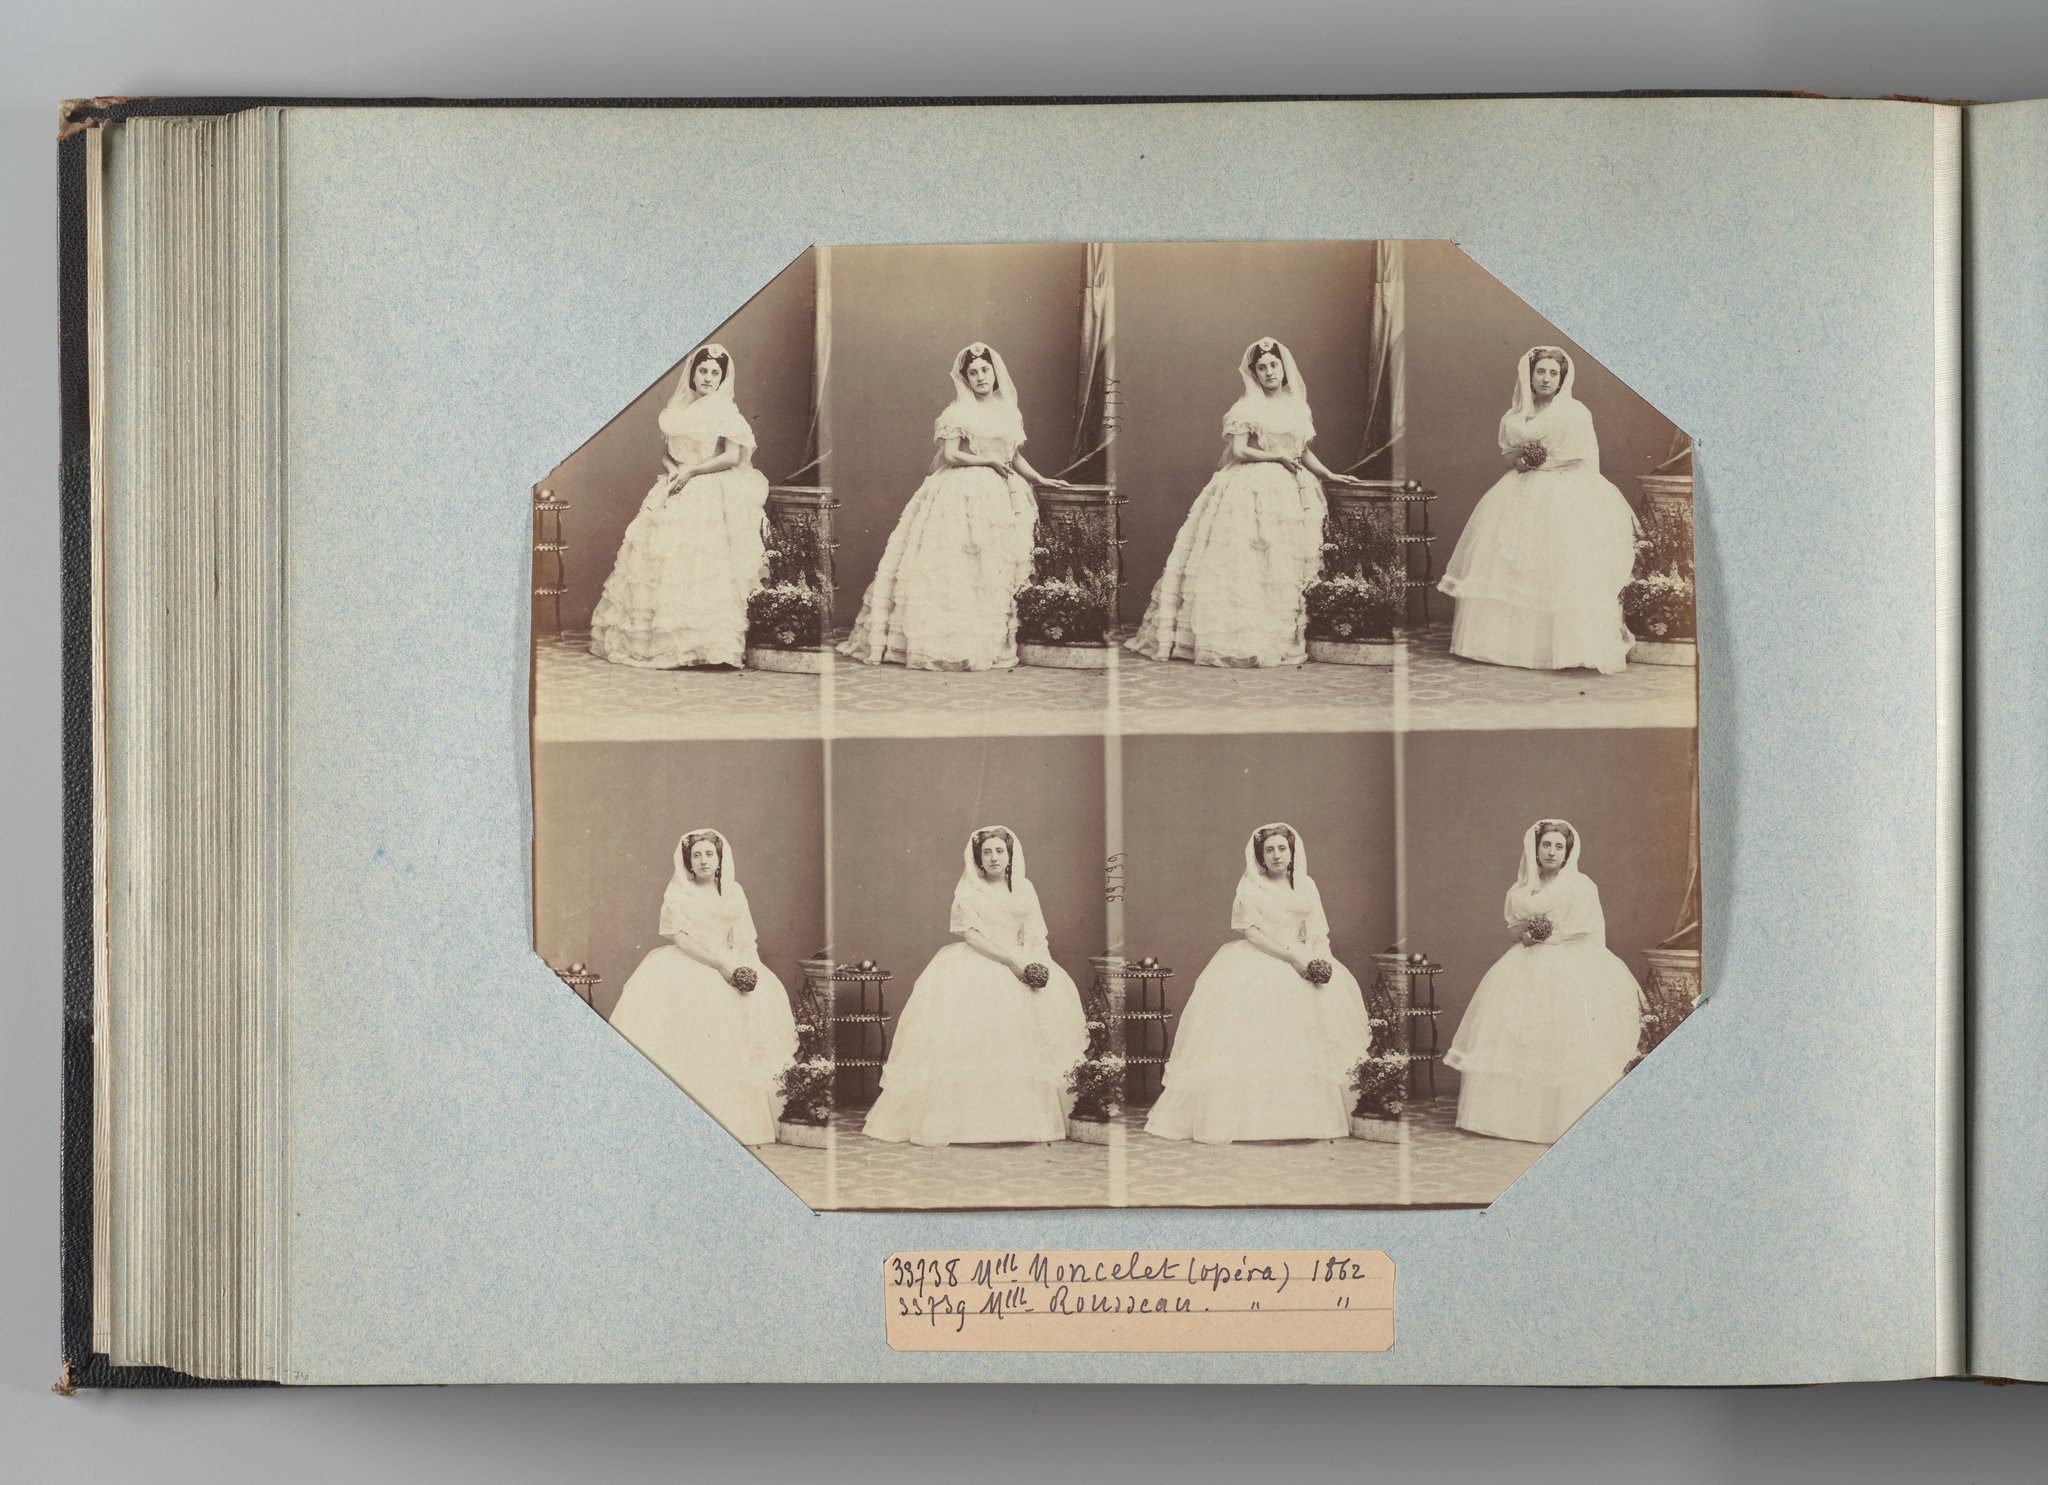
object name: photograph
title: Mlle Moncelet; Mlle Rousseau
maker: andré-adolphe-eugène disdéri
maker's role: artist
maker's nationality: french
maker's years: 1819-1889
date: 1862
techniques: albumen silver print, glass negative